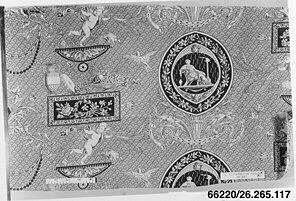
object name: furnishing textile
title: Pictorial print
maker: jean-baptiste huet i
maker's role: designer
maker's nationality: french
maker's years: 1745-1811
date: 1804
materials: cotton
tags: birds,putti